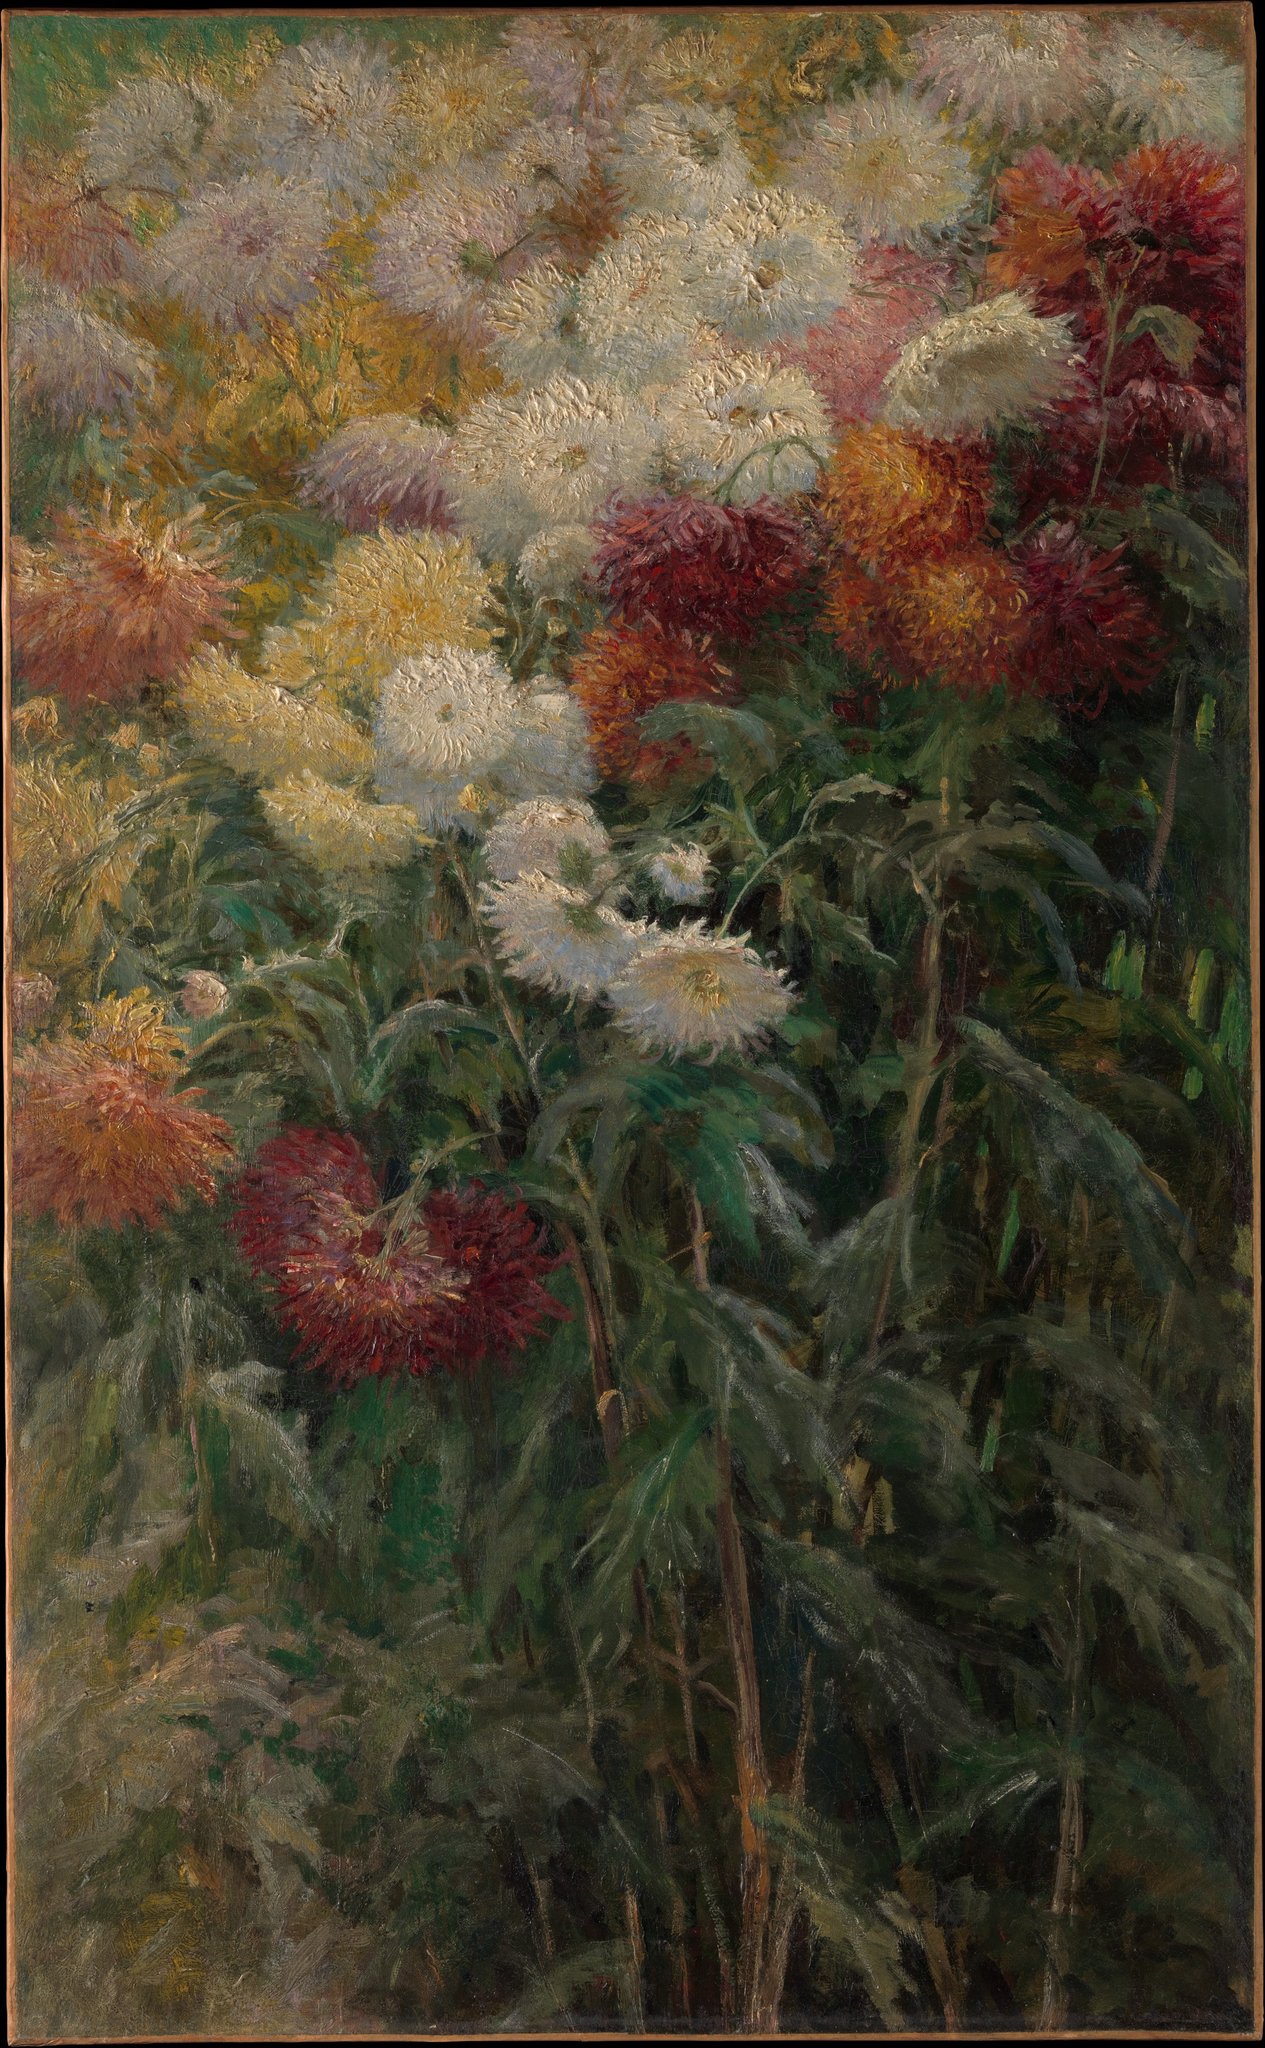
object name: painting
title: Chrysanthemums in the Garden at Petit-Gennevilliers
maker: gustave caillebotte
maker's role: artist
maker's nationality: french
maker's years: 1848-1894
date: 1893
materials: canvas, oil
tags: flowers,paris